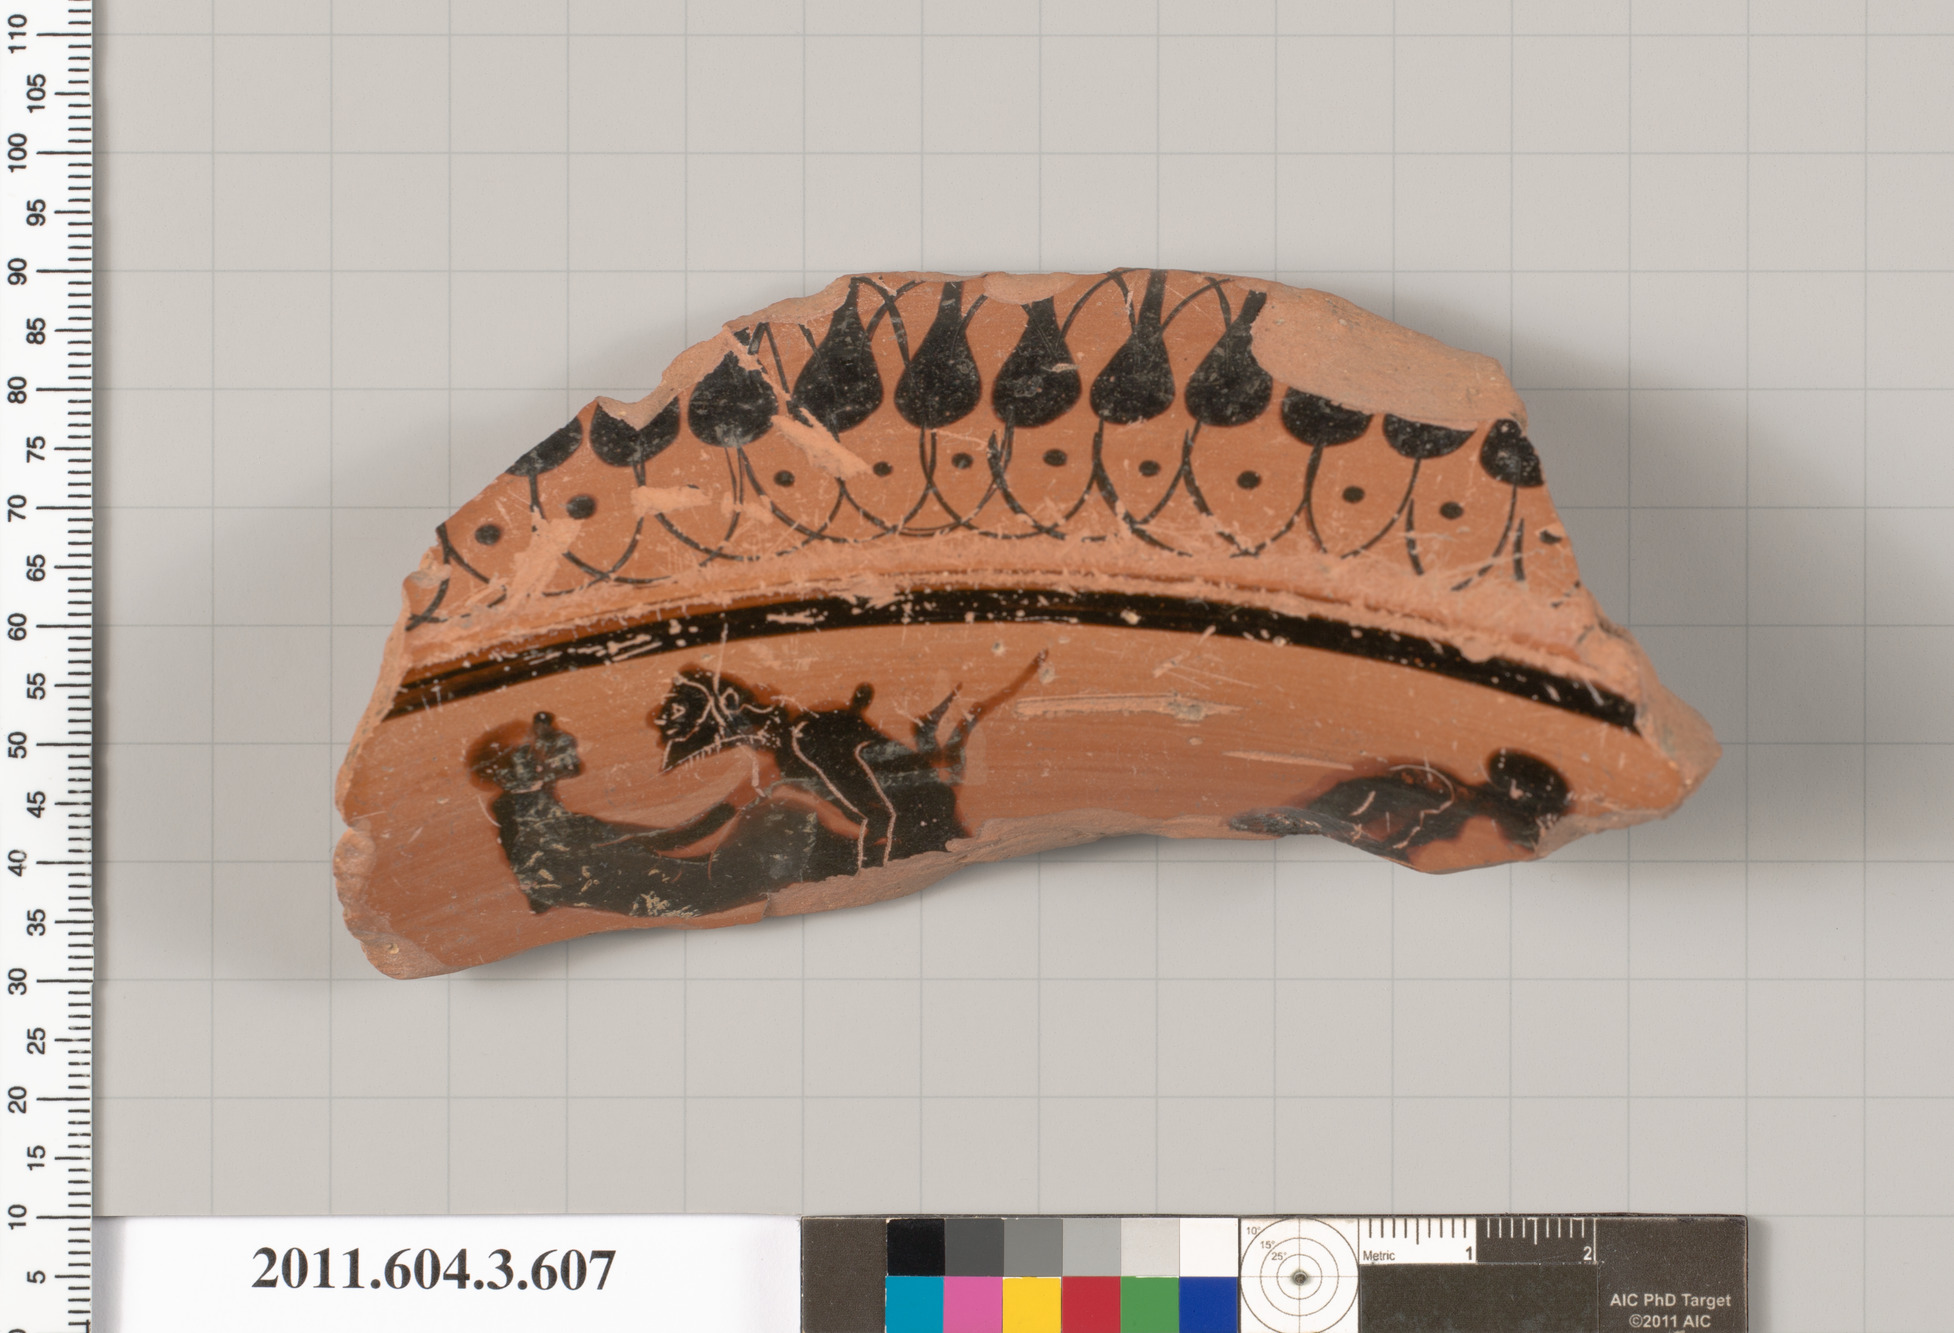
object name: column krater fragment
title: Terracotta fragment of a column-krater (bowl for mixing wine and water)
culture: greek, attic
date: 525-501 BCE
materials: terracotta